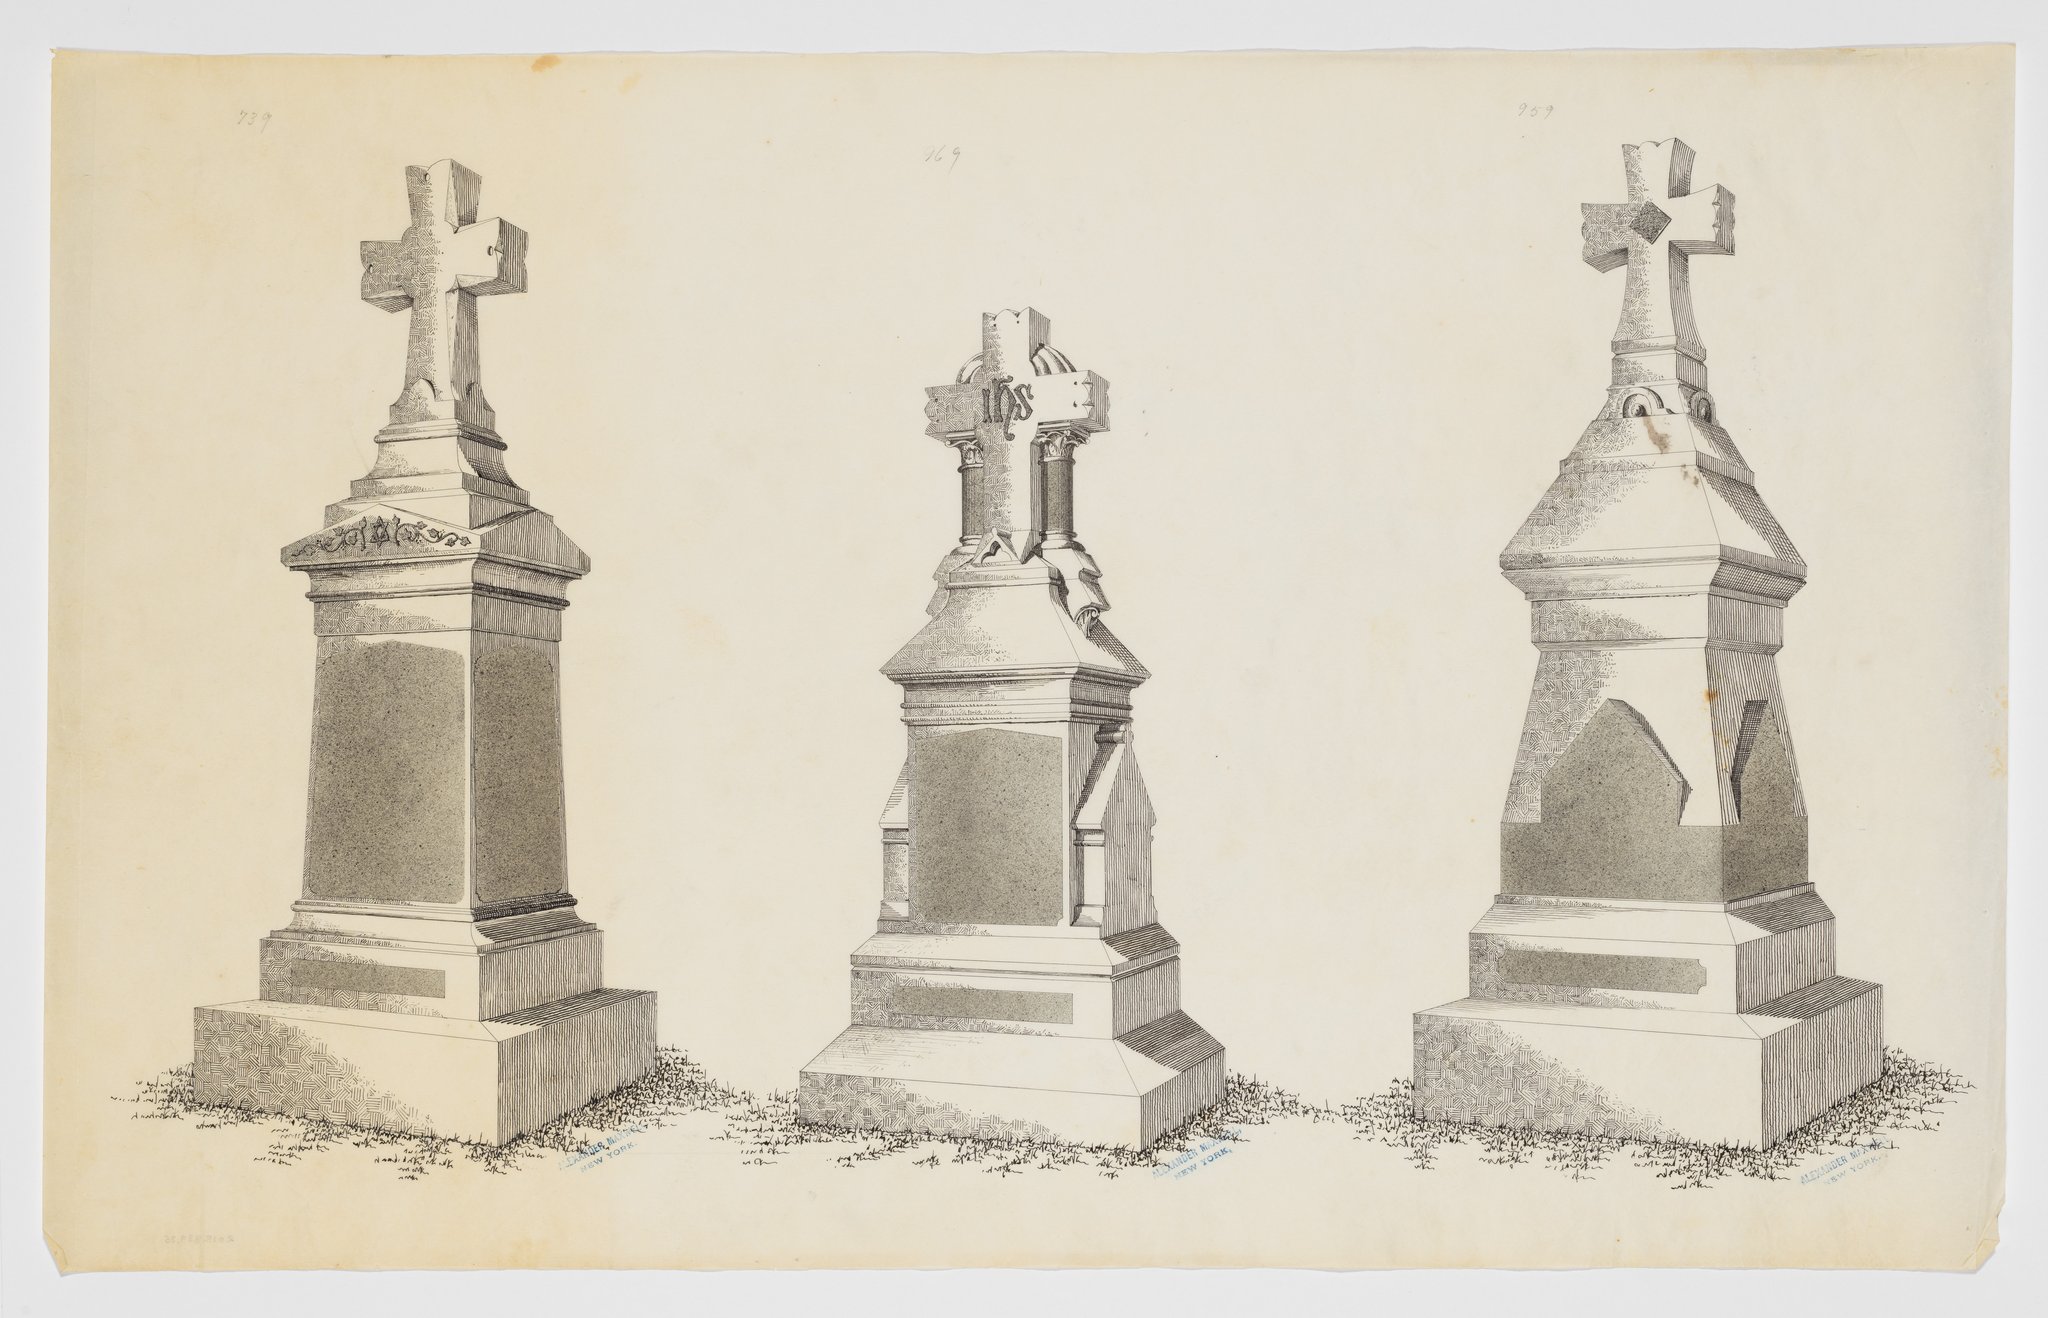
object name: drawing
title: Three Grave Monument Designs with Crosses, Nos. 739, 969, 959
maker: alexander maxwell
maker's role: artist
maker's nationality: american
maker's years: 1838-1880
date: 1840-1880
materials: ink, paper, skin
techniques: pen